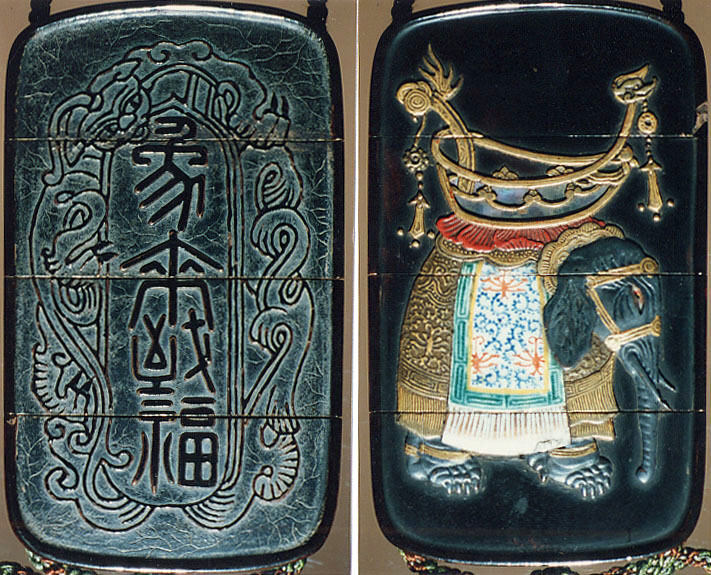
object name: inrō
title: Case (Inrō) with Design of Caparisoned Elephant (obverse); Characters in Panel (reverse)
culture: japanese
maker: fangshi mopu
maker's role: artist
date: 1701-1900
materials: ceramic, gold, lacquer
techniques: fundame, hiramakie, inlay, roiro, maki-e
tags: elephants